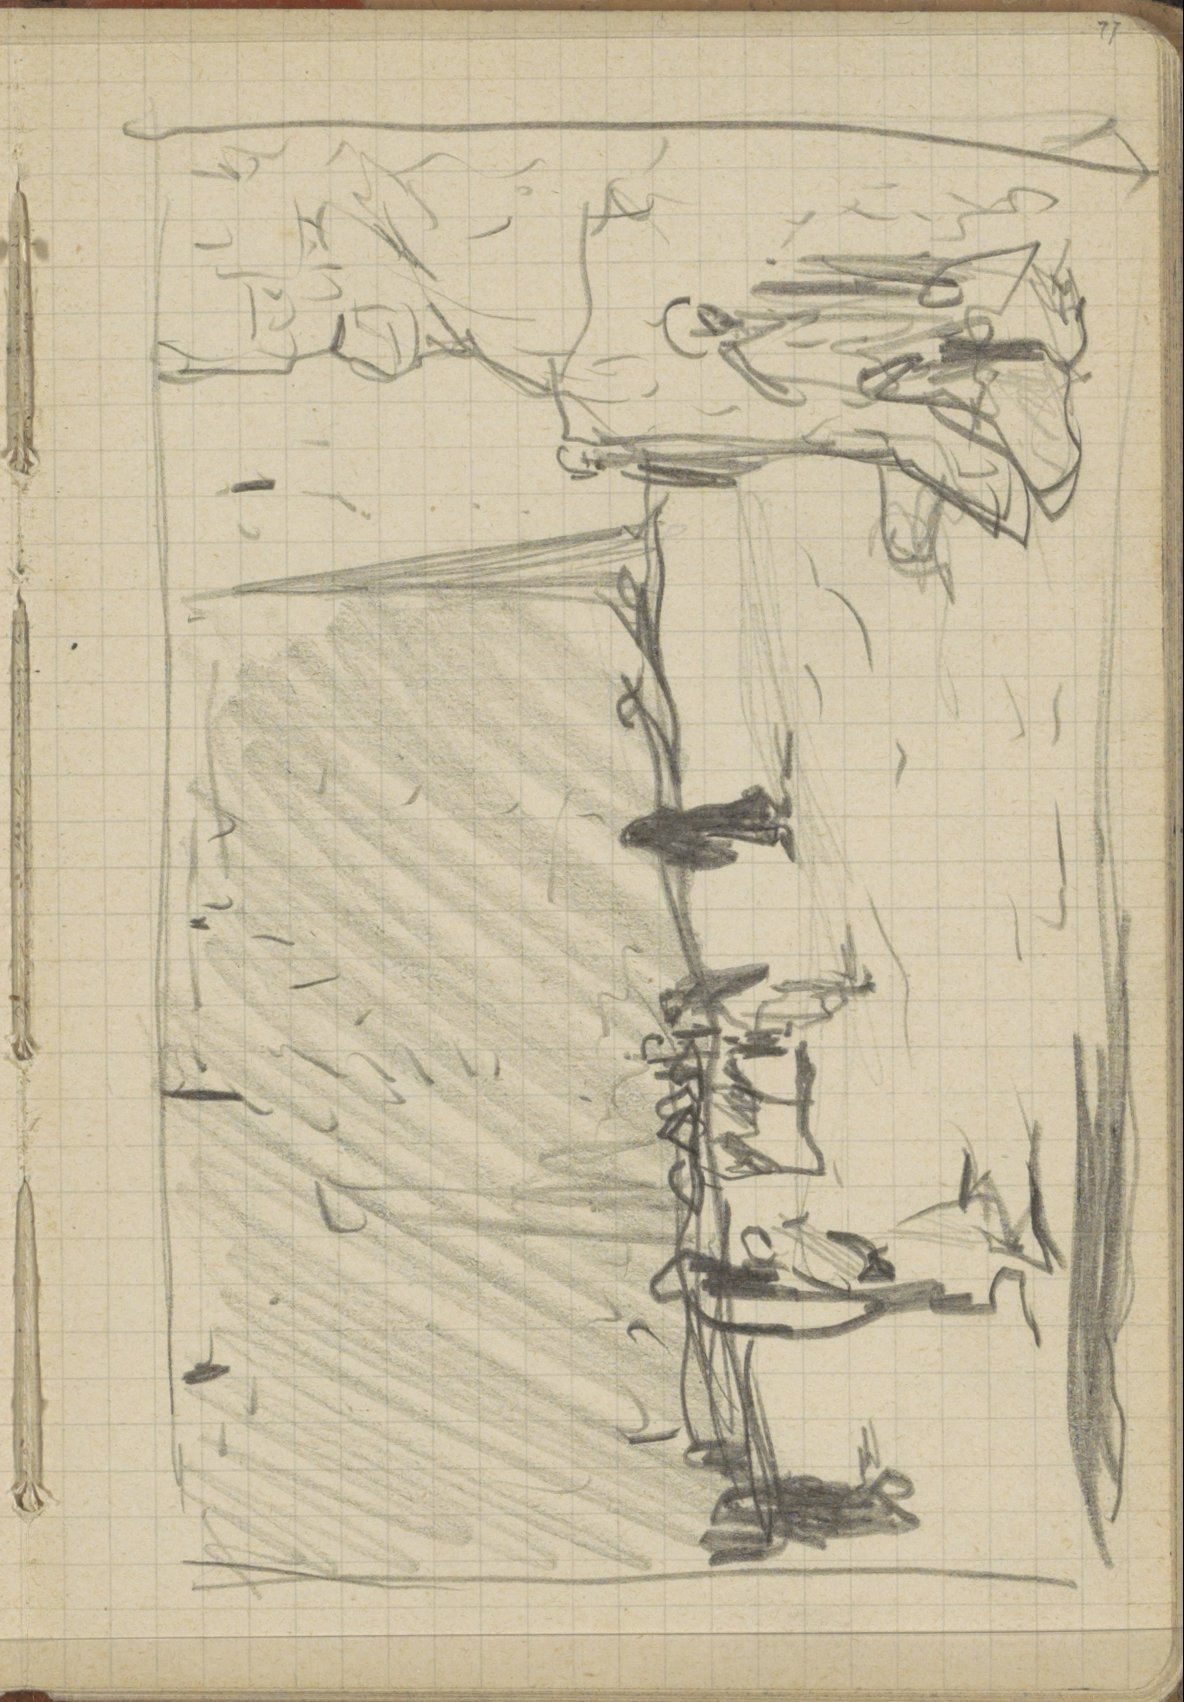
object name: sketchbook leaf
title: Straat met figuren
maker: marius bauer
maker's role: draughtsman, print maker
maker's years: 1867-1932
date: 1909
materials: pencil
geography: tunis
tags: street (+ city(-scape) with figures, staffage)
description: Pagina 77 uit een schetsboek met 67 bladen.